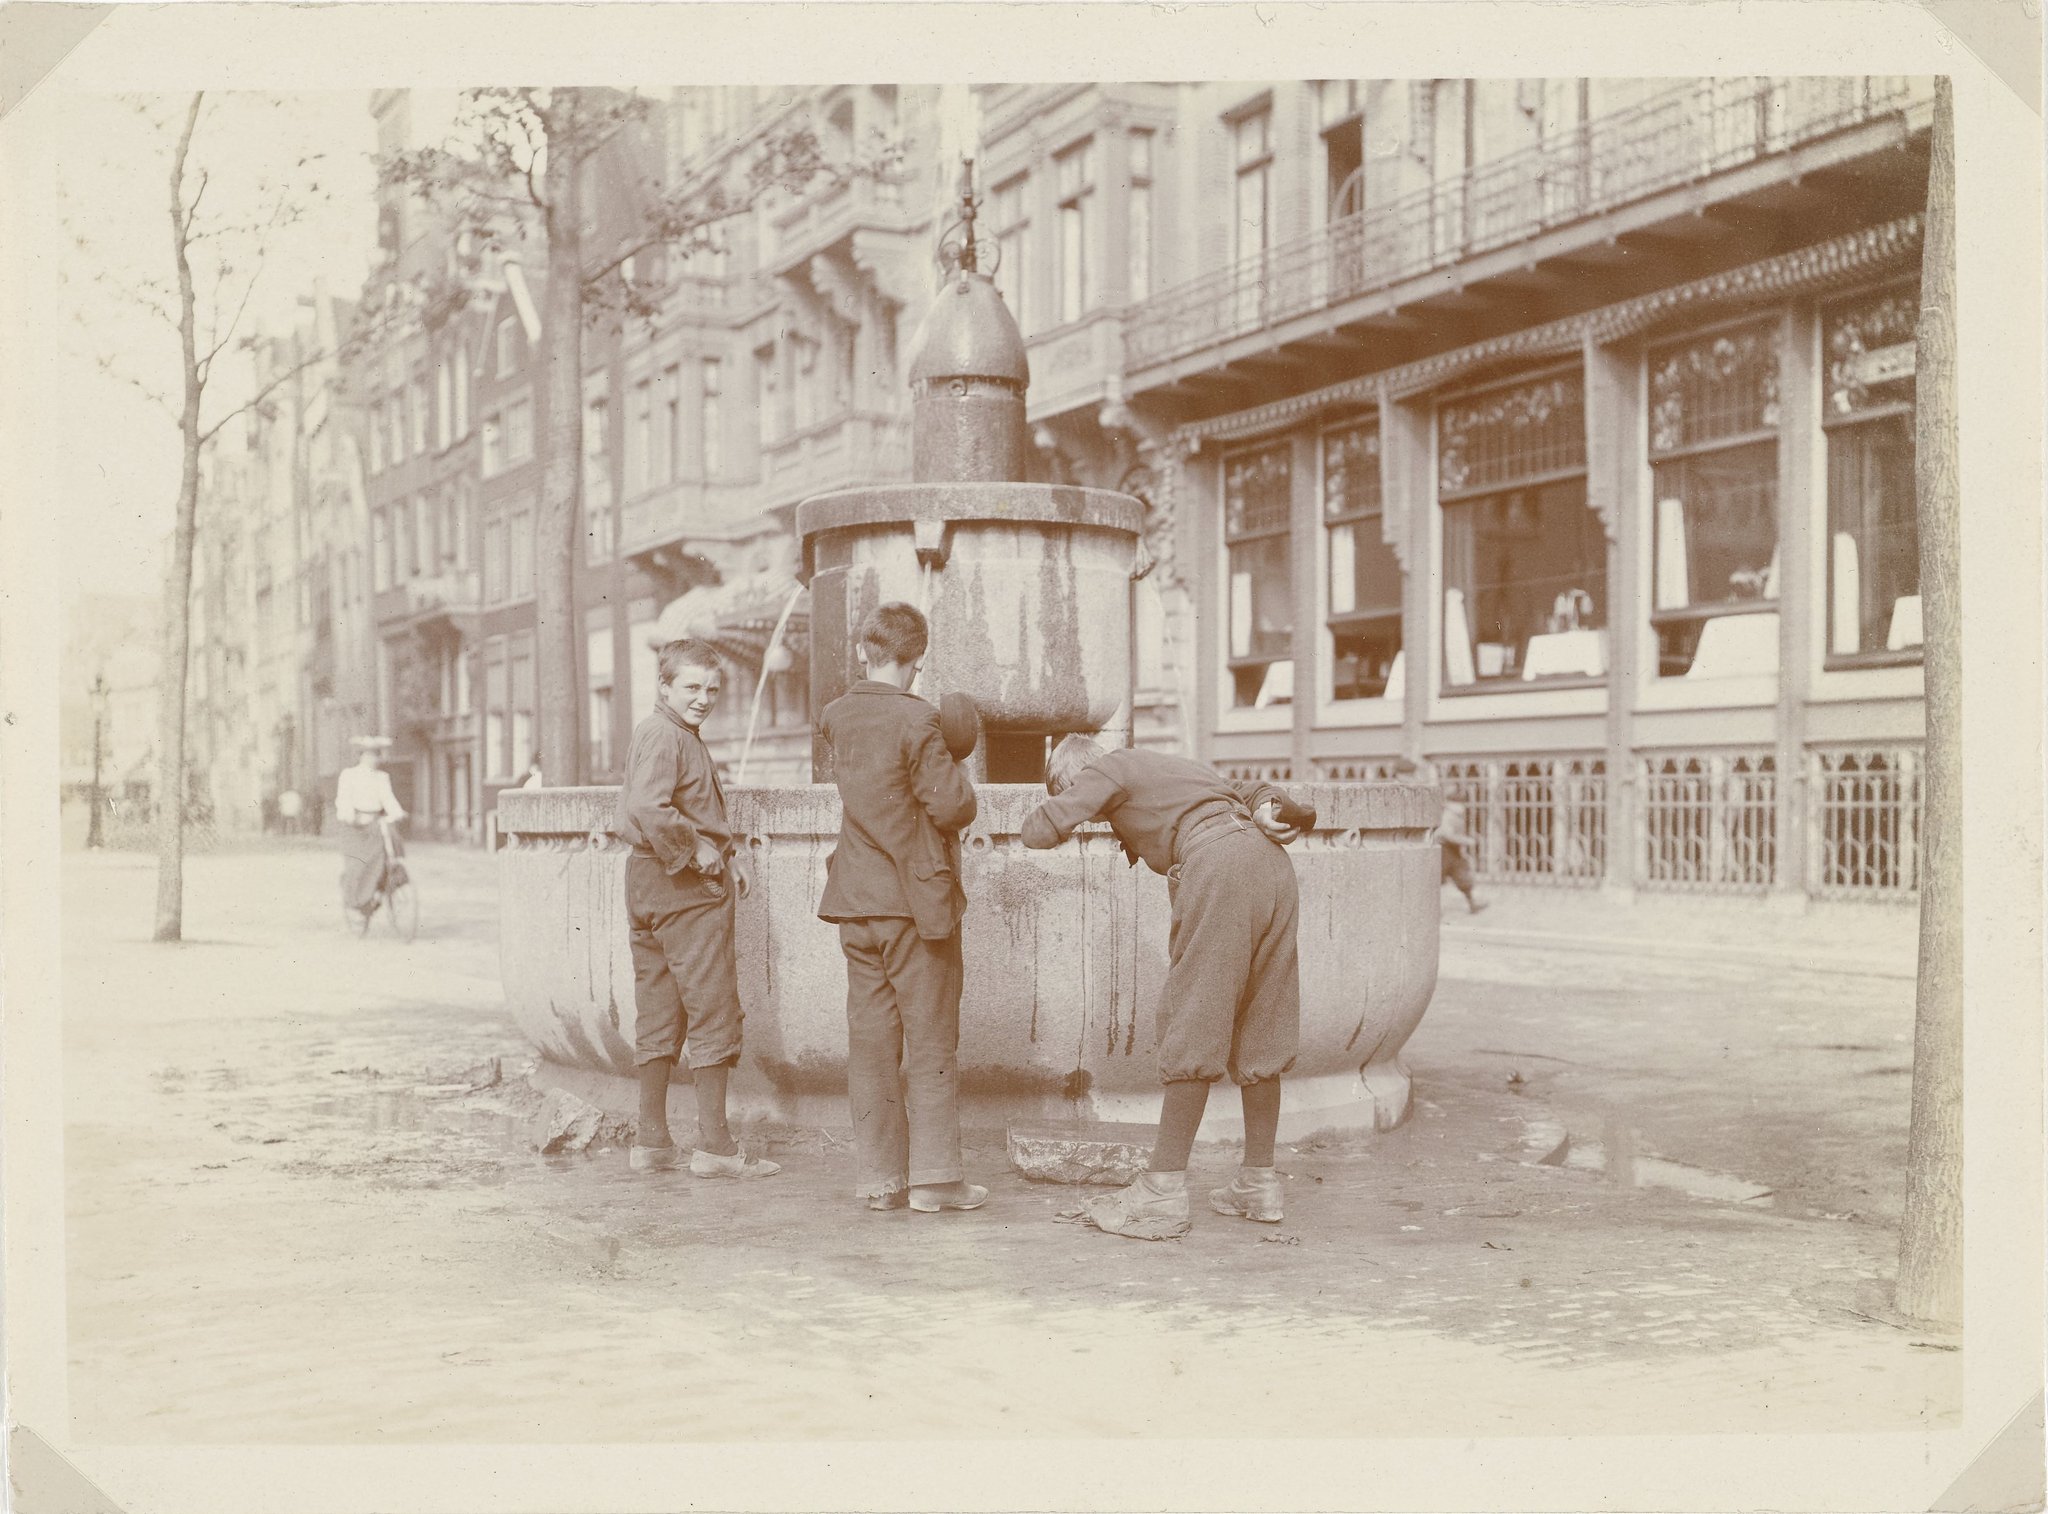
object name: photograph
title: Drie jongens bij een fontein op het Beursplein te Amsterdam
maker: james higson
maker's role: politician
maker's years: 1862-1933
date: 1904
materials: paper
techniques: gelatin silver print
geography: amsterdam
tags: garden fountain, ornamental fountain